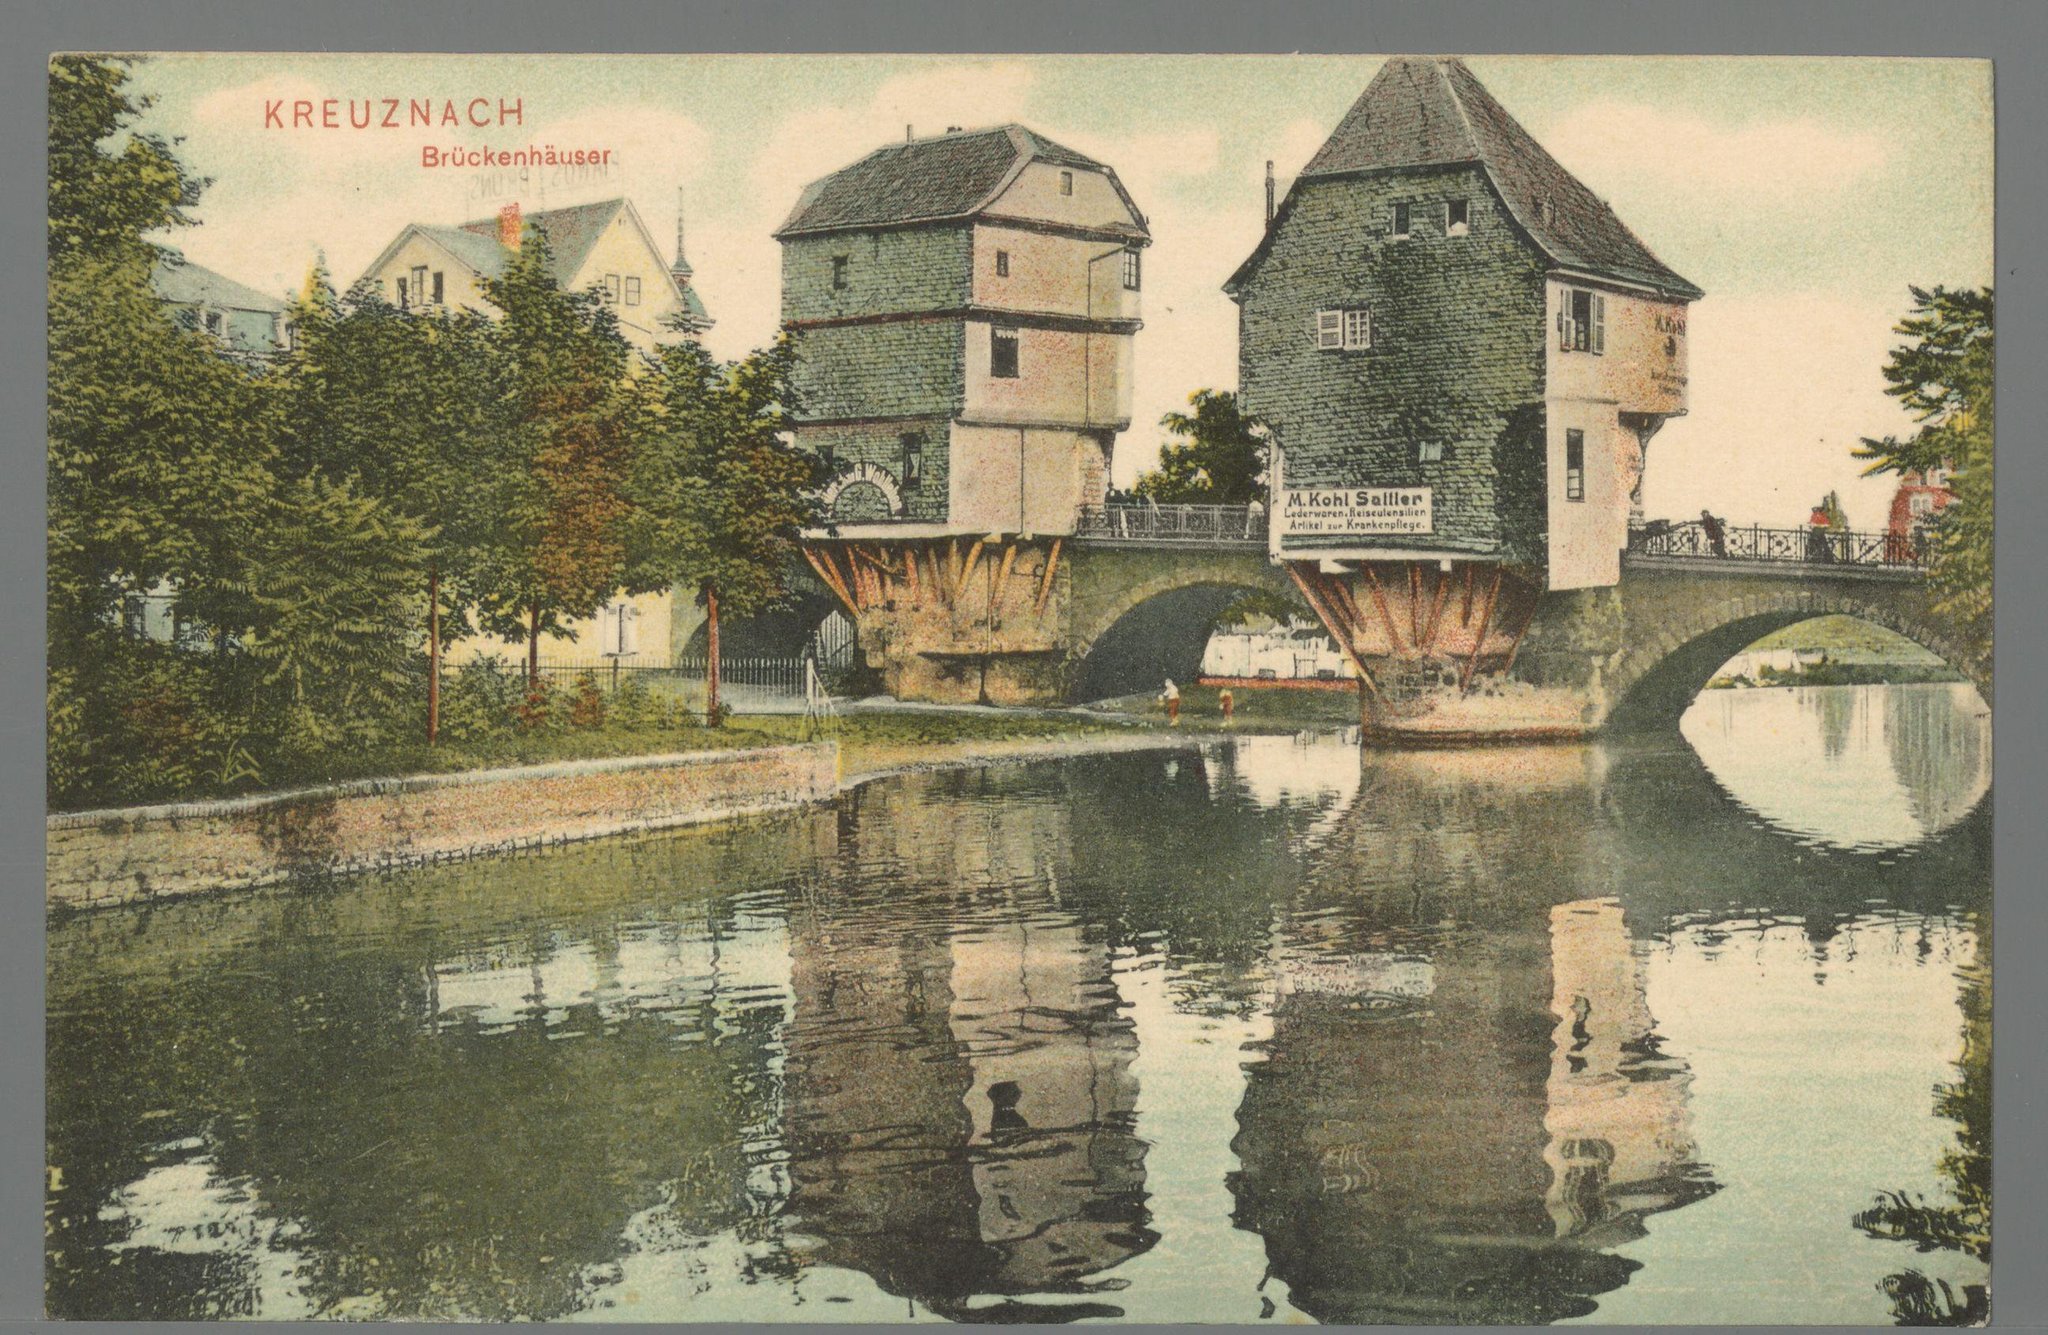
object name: ansichtkaart, prentbriefkaart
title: Kreuznach. Brückenhäuser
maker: Anonymous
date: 1907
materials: cardboard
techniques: photograph, lithograph, writing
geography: leipzig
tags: canals, waters (in city), bridge in city across river, canal, etc.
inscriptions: date